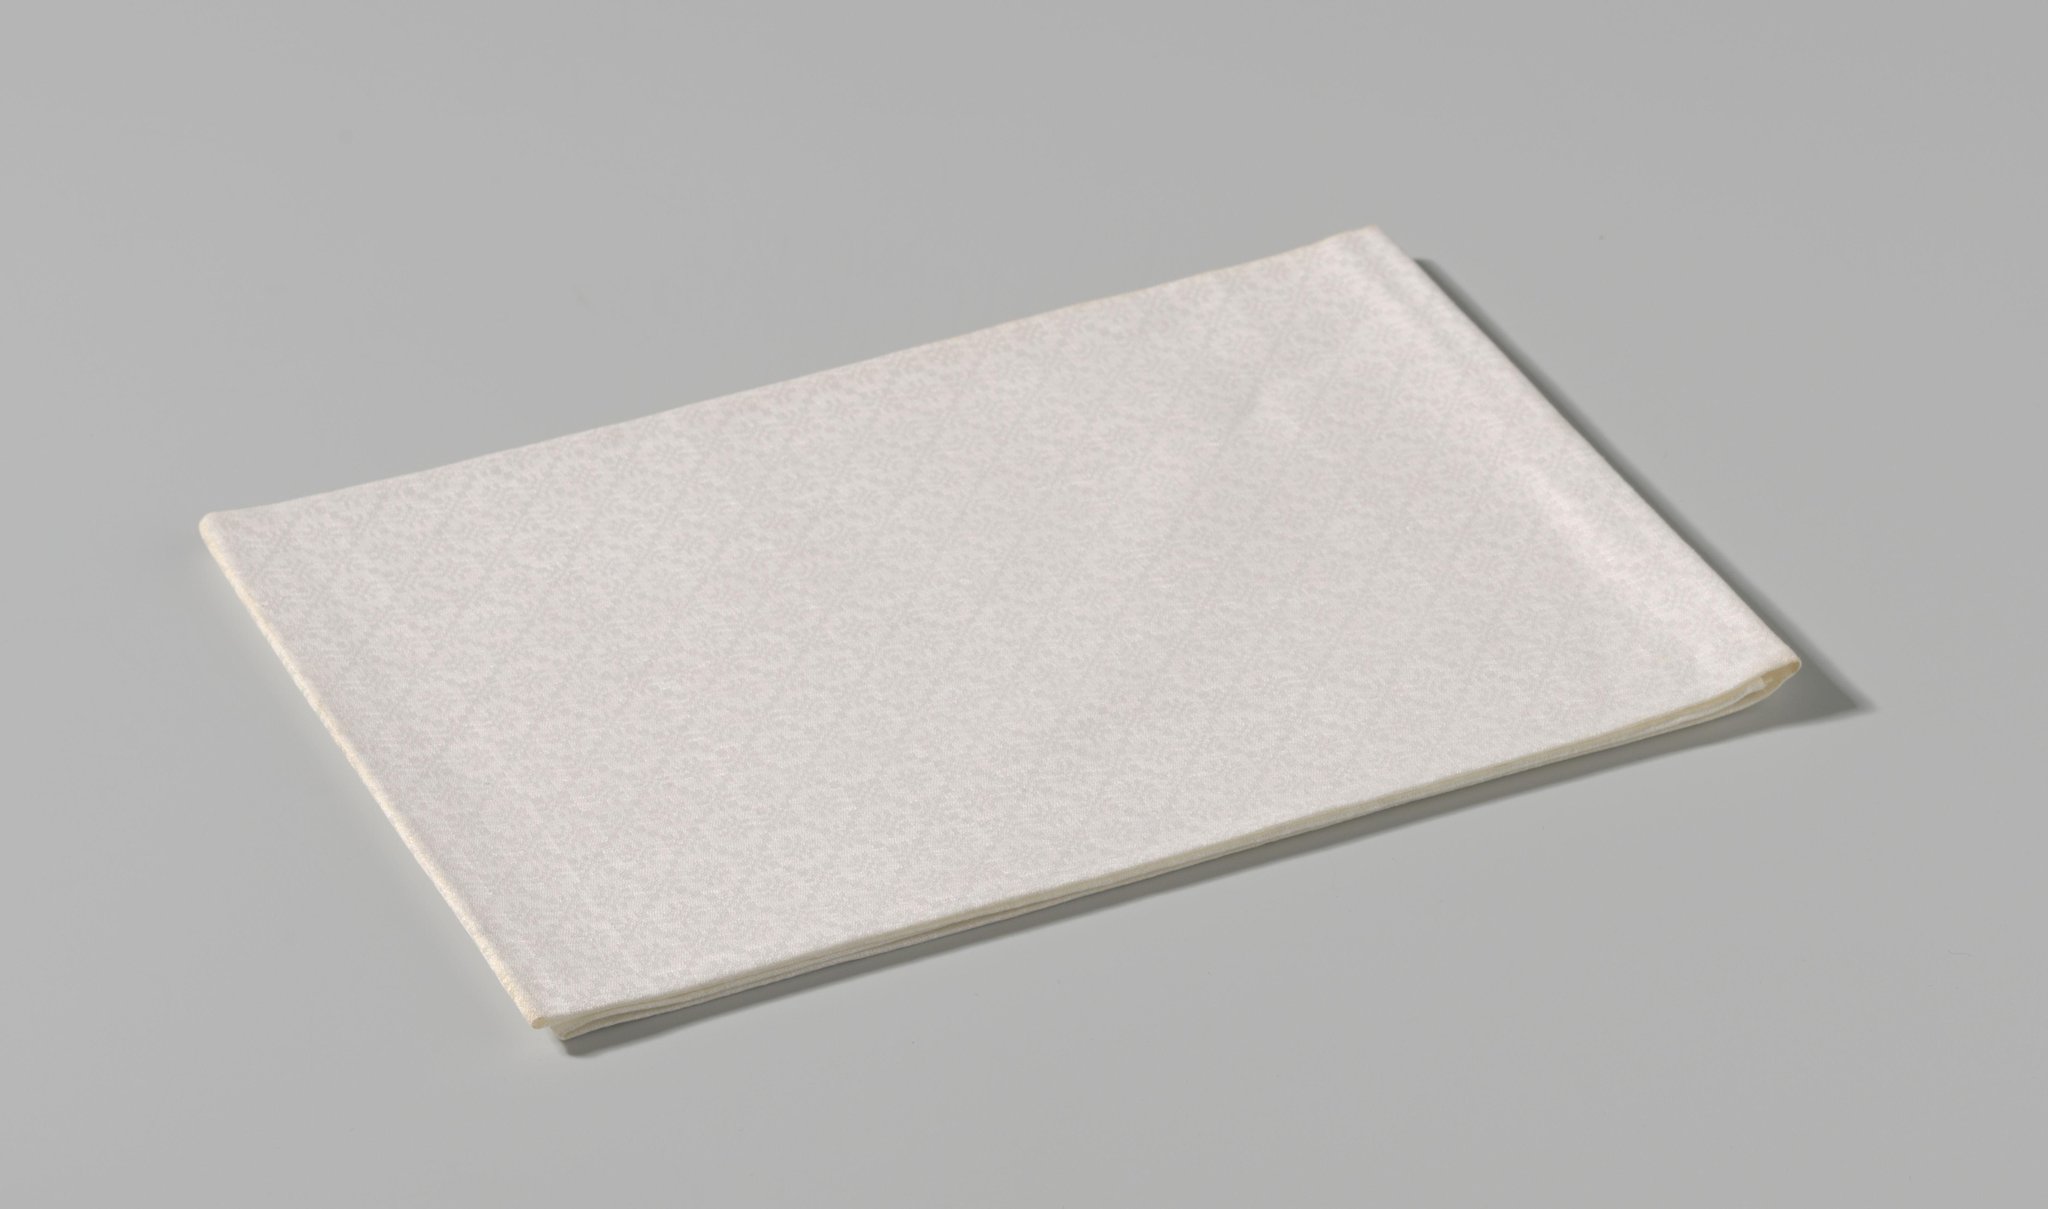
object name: napkin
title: Servet met pellenpatroon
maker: Anonymous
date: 1700-1775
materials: linen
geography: northern netherlands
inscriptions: mark: ‘24’, mark: ‘HB’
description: Servet van wit linnendamast met een pellenpatroon.